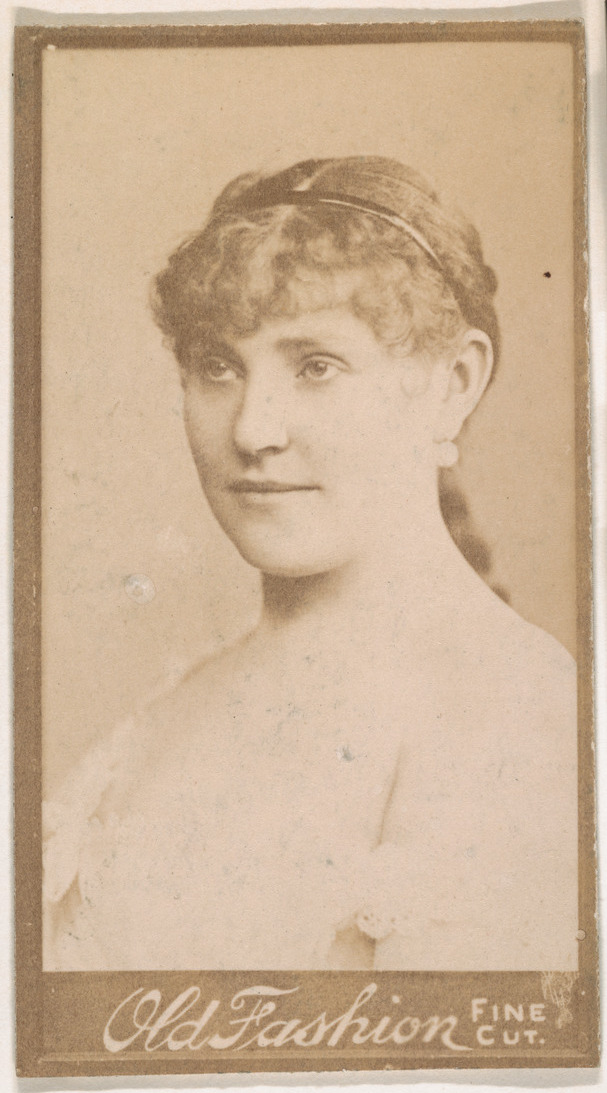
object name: photograph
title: Portrait of actress, from the Actresses series (N664) promoting Old Fashion Fine Cut Tobacco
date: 1888-1890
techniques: albumen silver print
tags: portraits,women,actresses